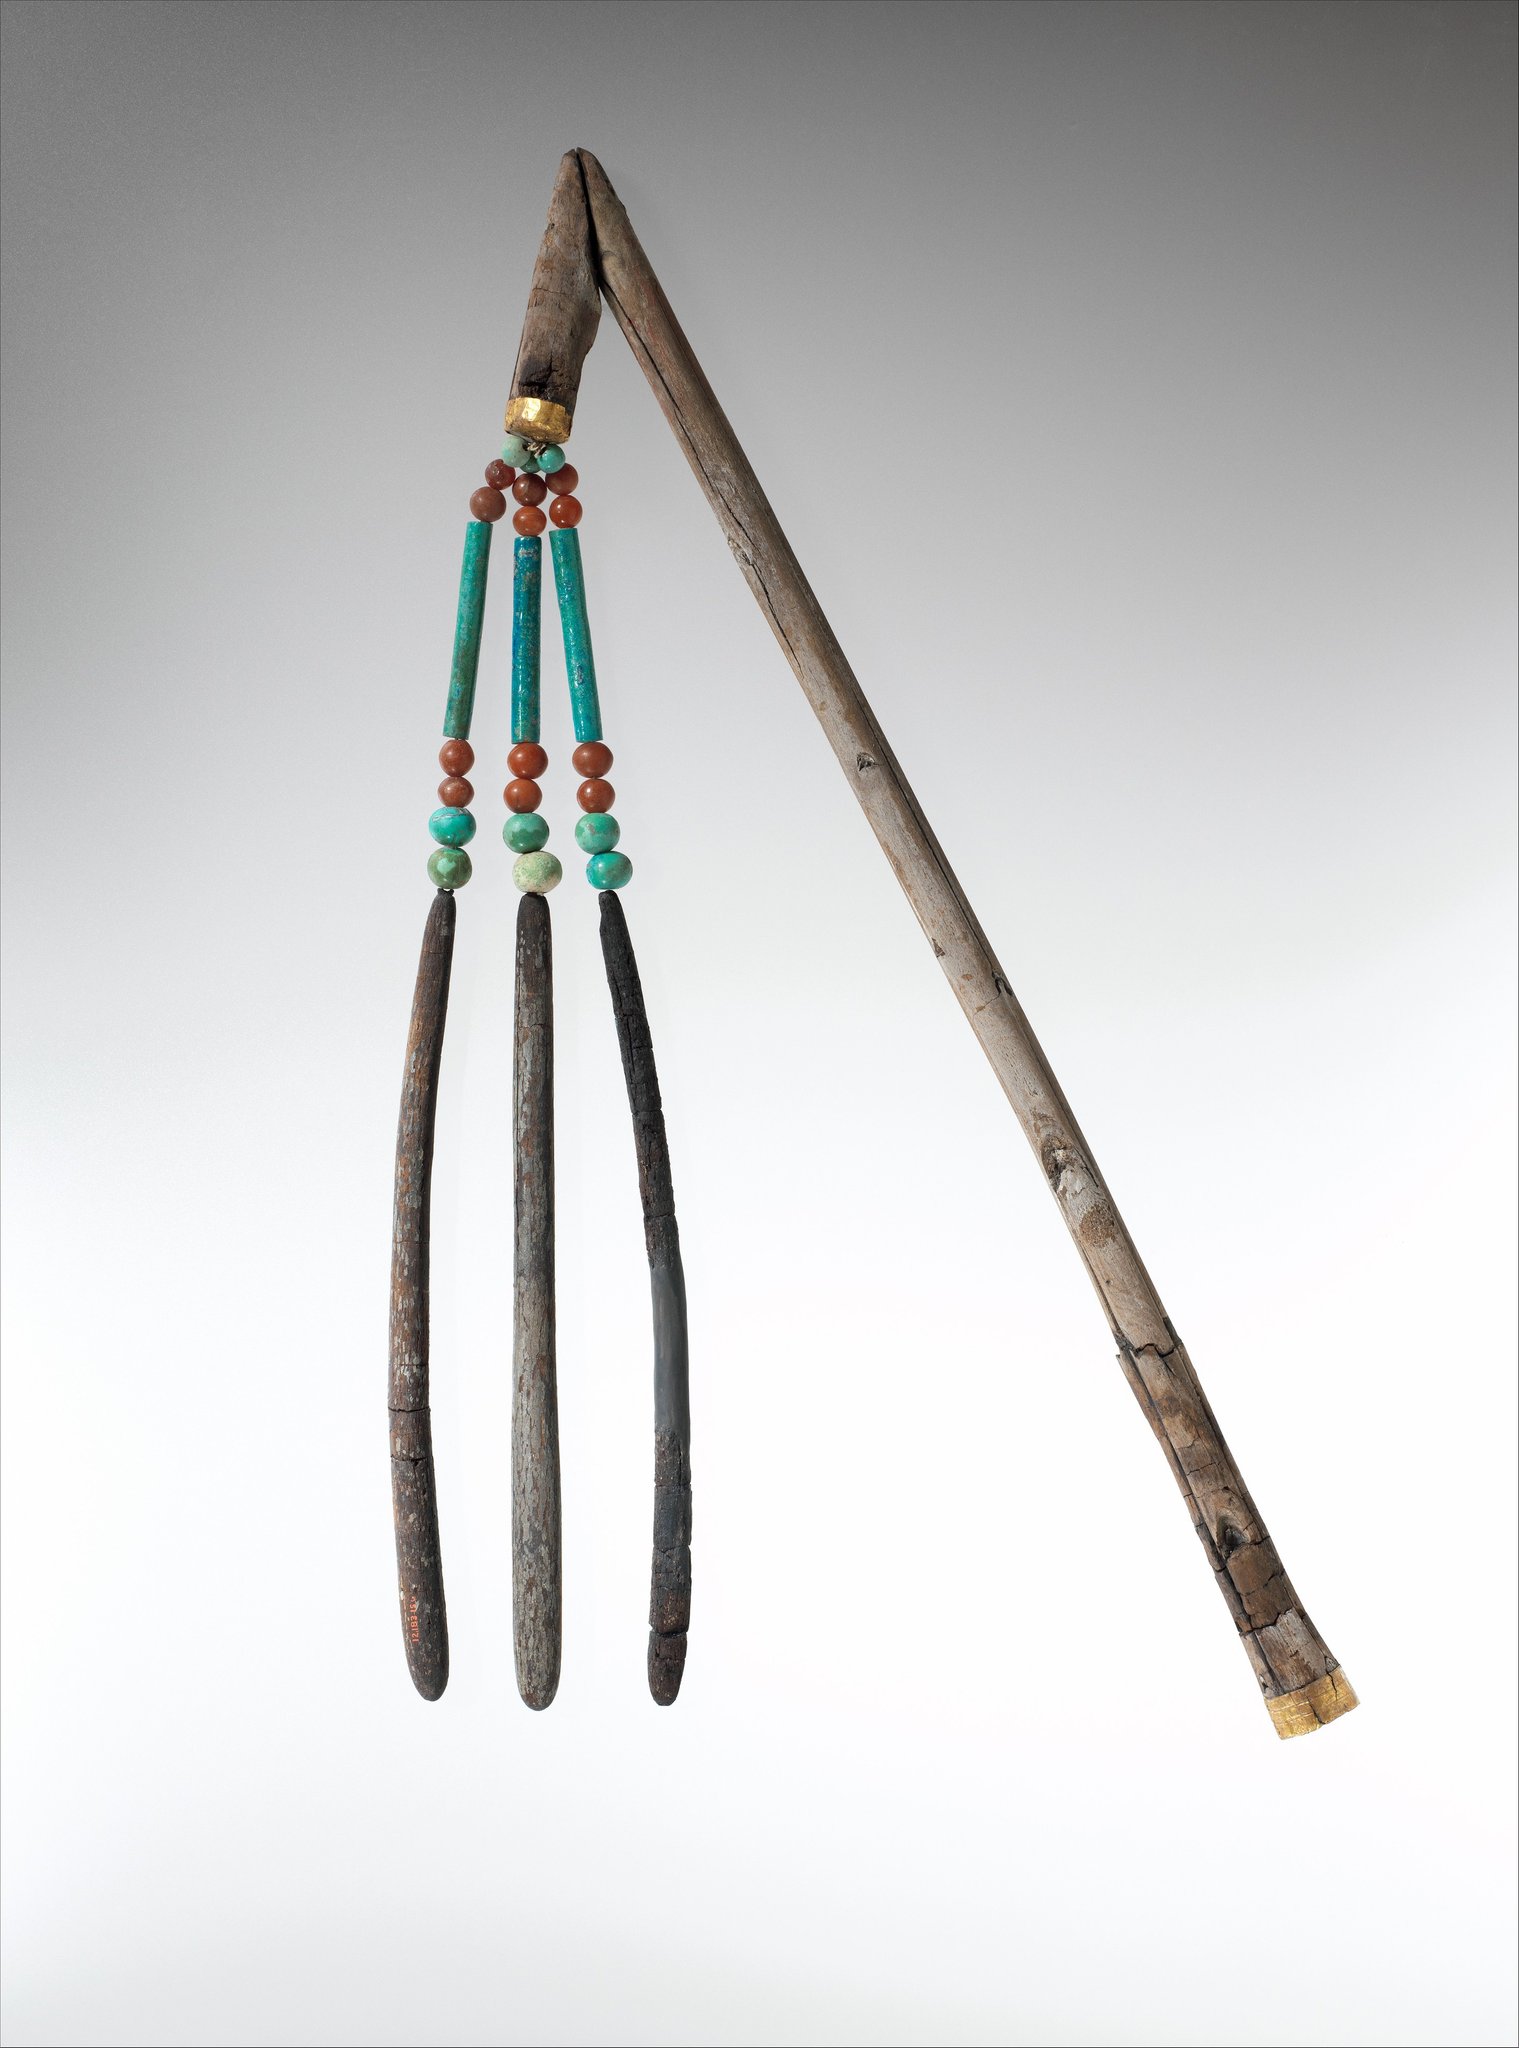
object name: scepter, hapiankhtifi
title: Flail of Hapiankhtifi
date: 1981-1802 BCE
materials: gemstone, faience, gold leaf, wood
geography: egypt